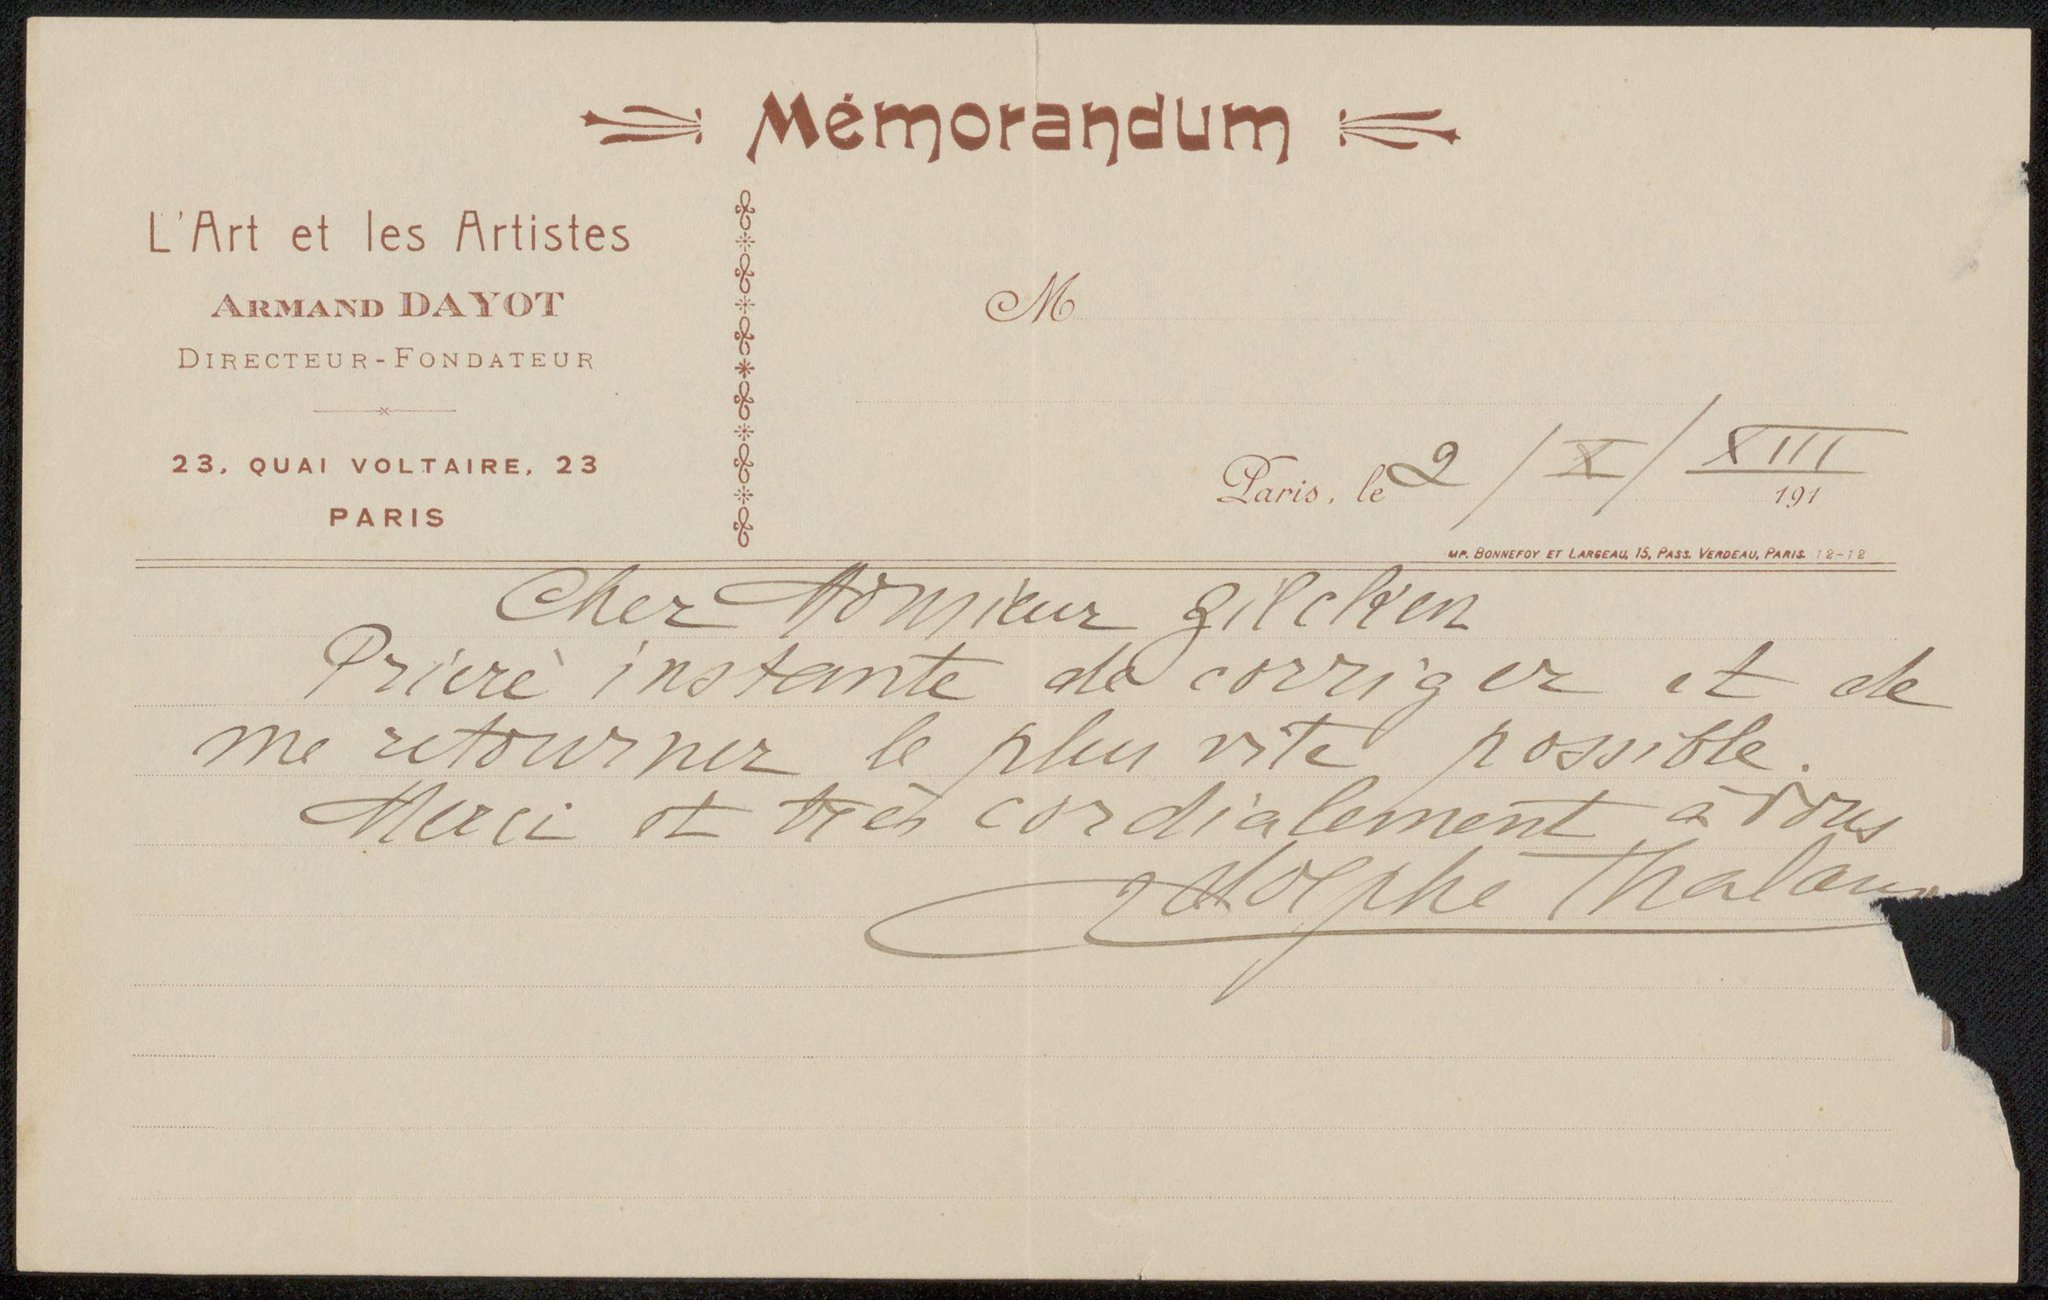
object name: letter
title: Brief aan Philip Zilcken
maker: adolphe thalasso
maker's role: criticus, dichter, dramaturg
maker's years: 1858-1919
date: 1913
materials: ink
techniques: pen, printing, writing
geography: paris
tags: the hague, painter, draughtsman, philip zilcken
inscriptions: collector's mark: ‘RPK’